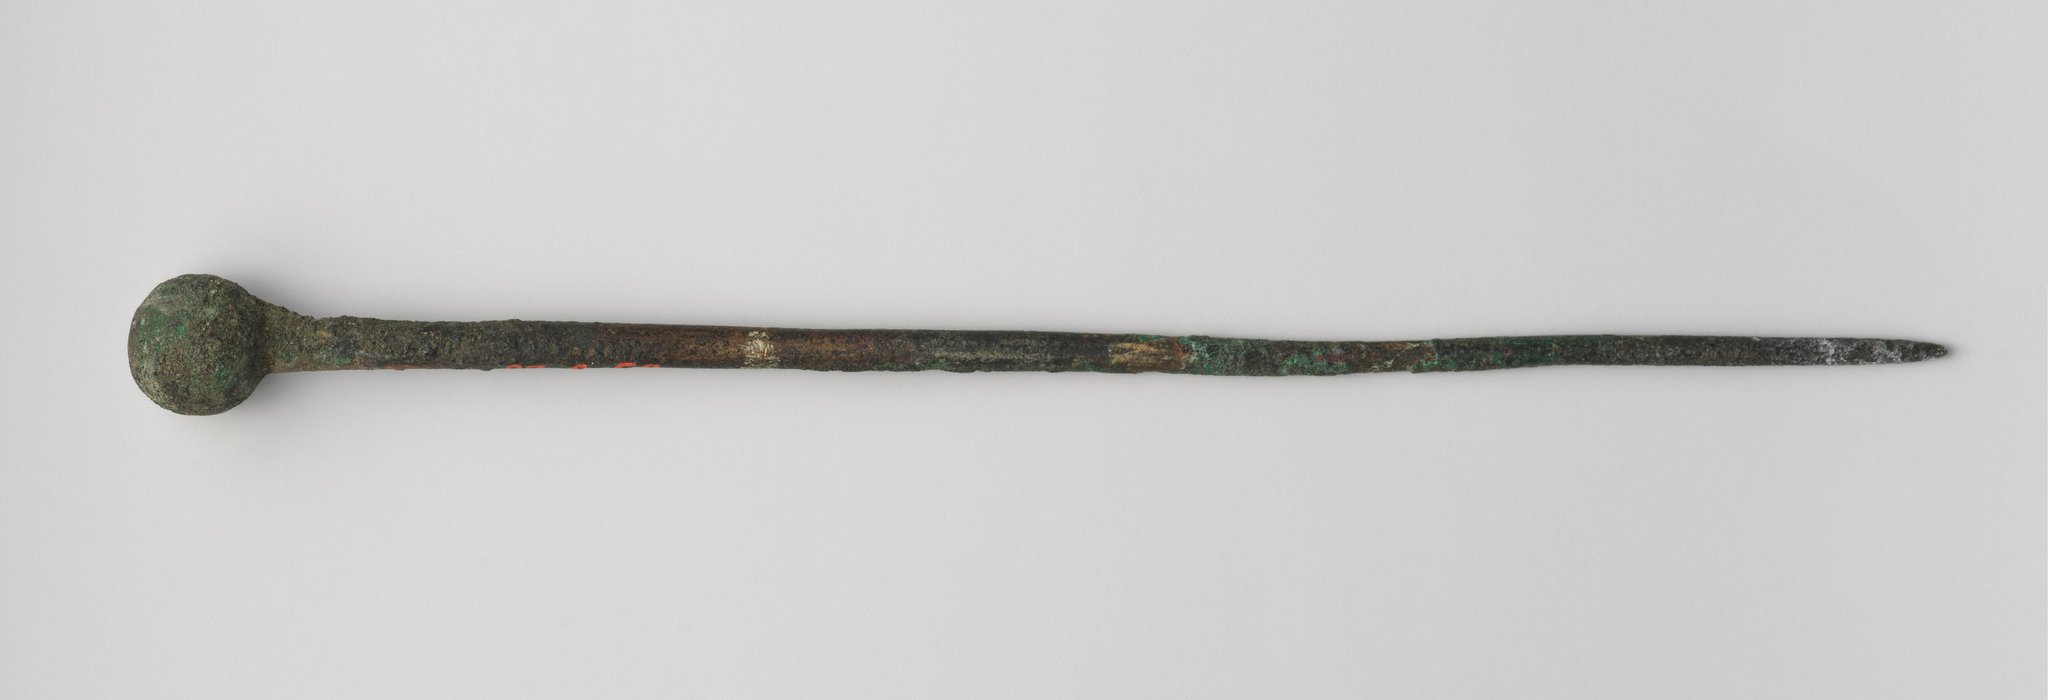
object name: tool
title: Implement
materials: copper alloy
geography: egypt